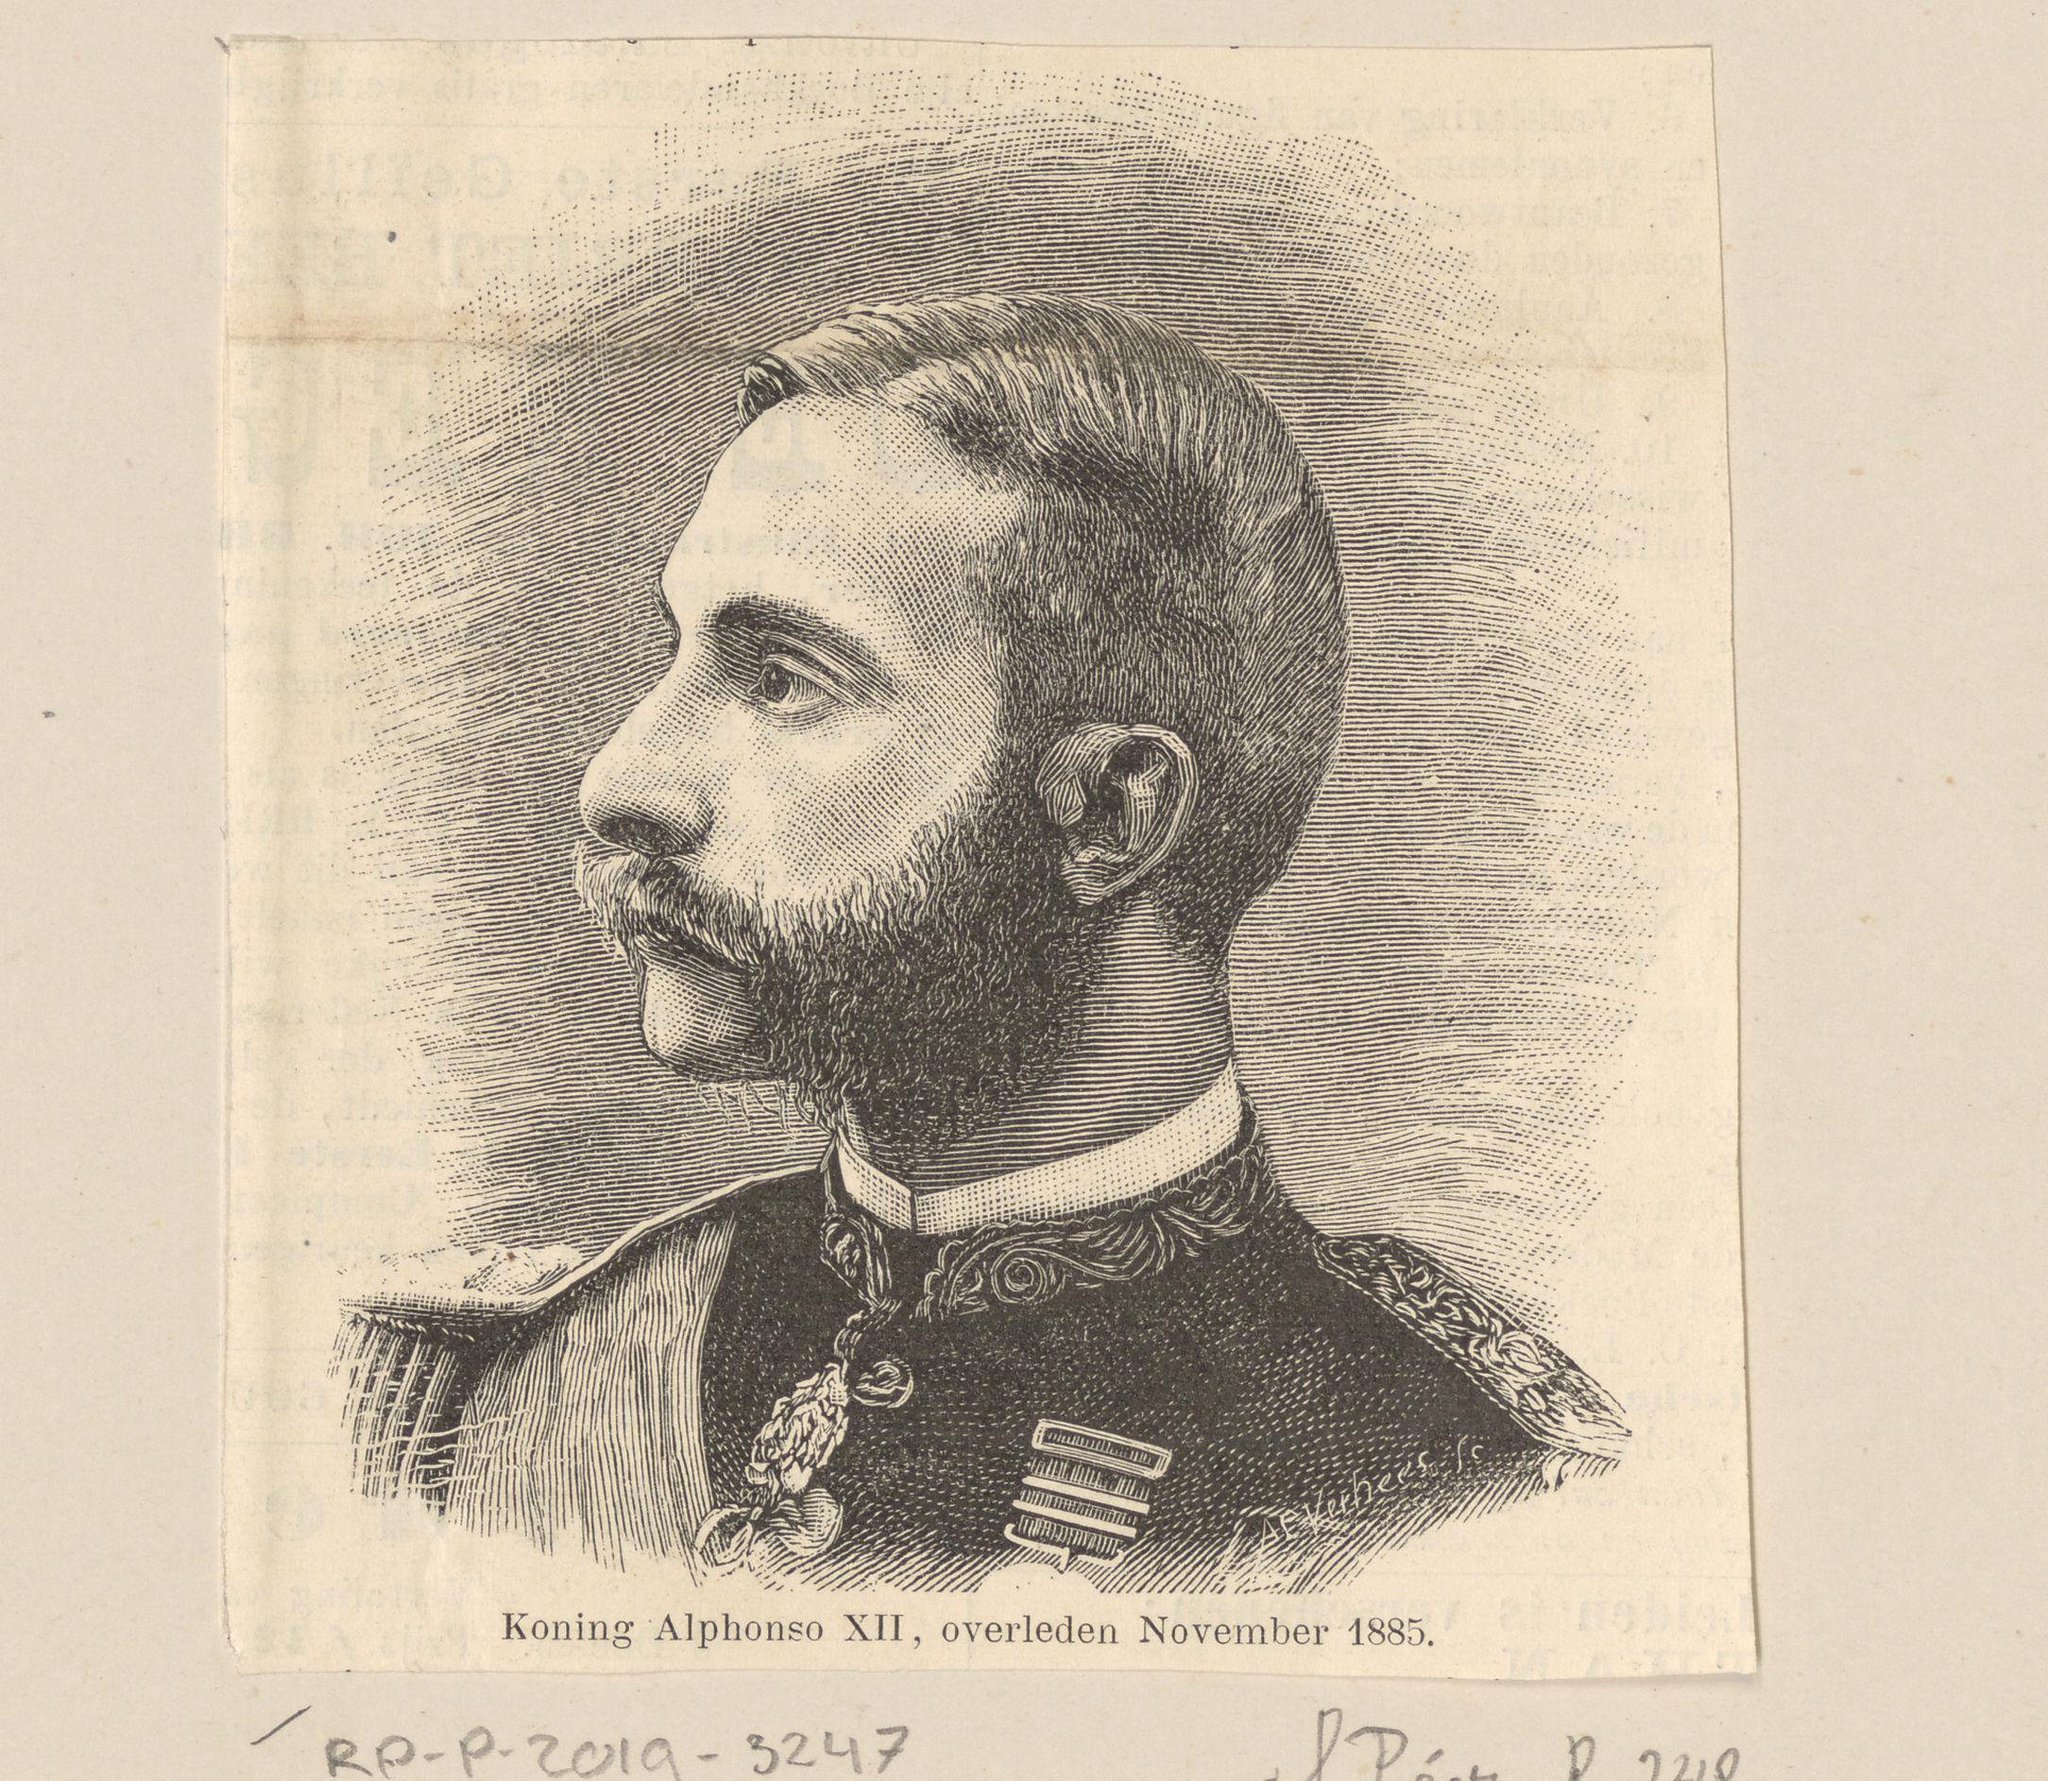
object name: print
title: Portret van Alfonso XII, koning van Spanje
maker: arnoldus cornelius verhees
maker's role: print maker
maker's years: 1859-1929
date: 1885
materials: paper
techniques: letterpress printing, engraving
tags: historical persons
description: Prent uit: Uit alle hemelstreken. Bijblad van Eigen haard. Haarlem: Tjeenk Willink, 1885, nr. 49.